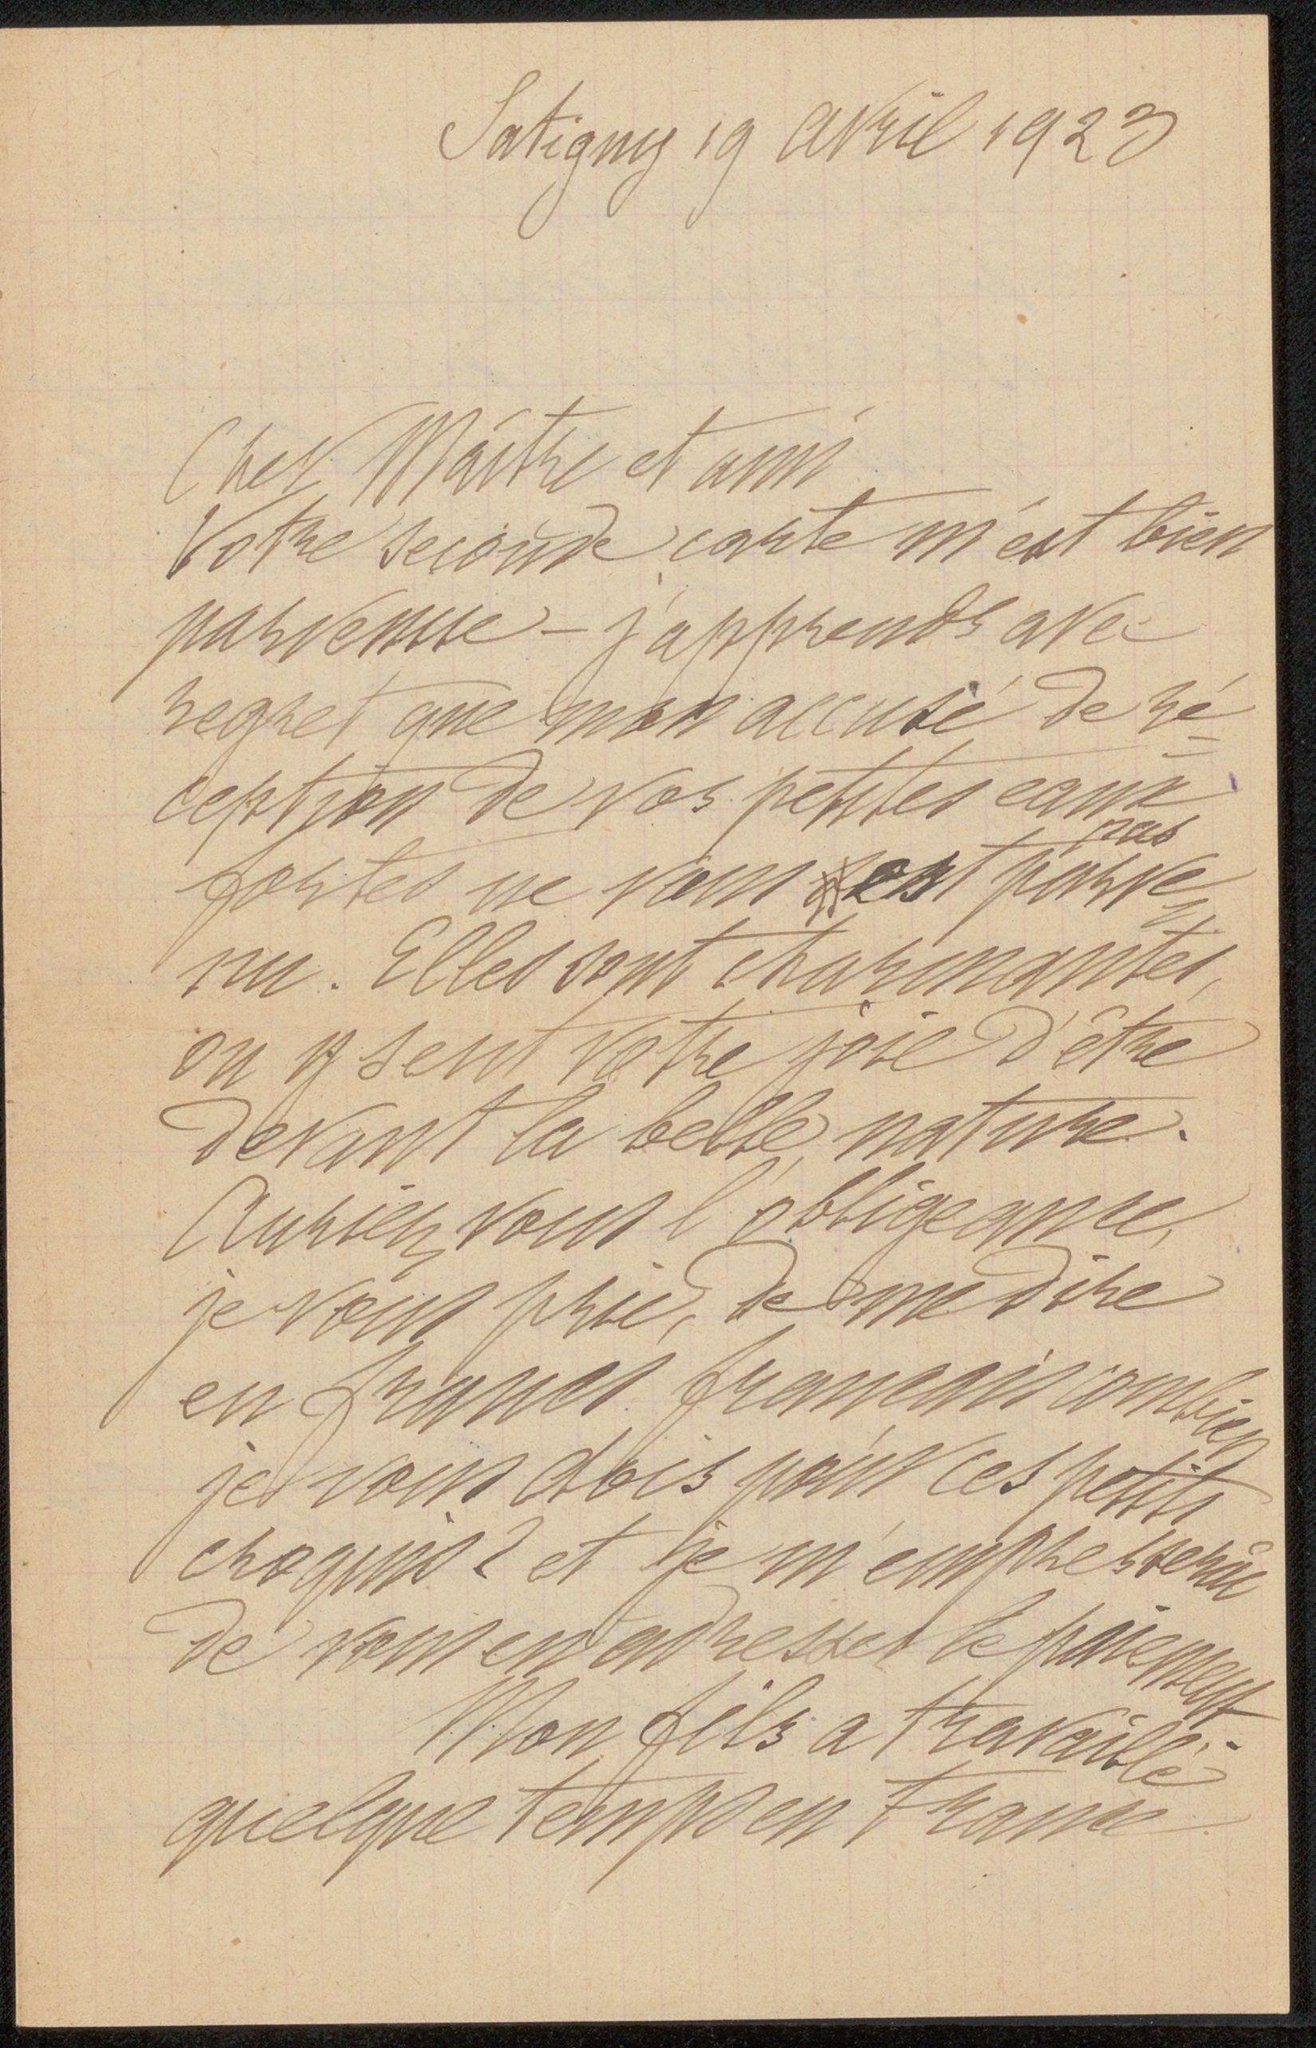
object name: letter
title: Brief aan Philip Zilcken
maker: alphonse stengelin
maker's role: painter, print maker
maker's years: 1852-1938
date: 1923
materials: ink, pencil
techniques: pen, writing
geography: satigny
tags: amsterdam, abraham bredius, the hague, painter, draughtsman, philip zilcken, art trade, art shop, the graphic arts, family life, painting (including book-illumination, miniature-painting), exhibition ~ art, art collecting, money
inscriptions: collector's mark: ‘RPK’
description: Envelop bevat aantekening van Philip Zilcken.